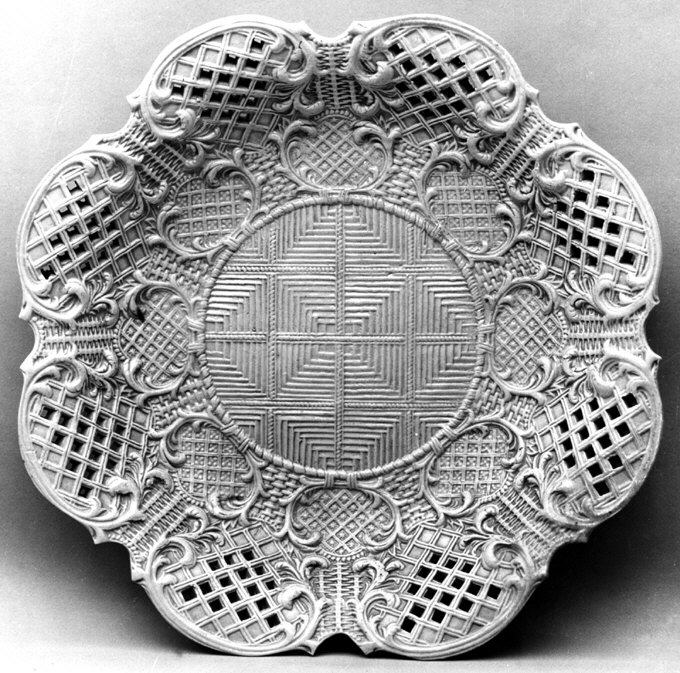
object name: dish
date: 1760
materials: stoneware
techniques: salt glaze